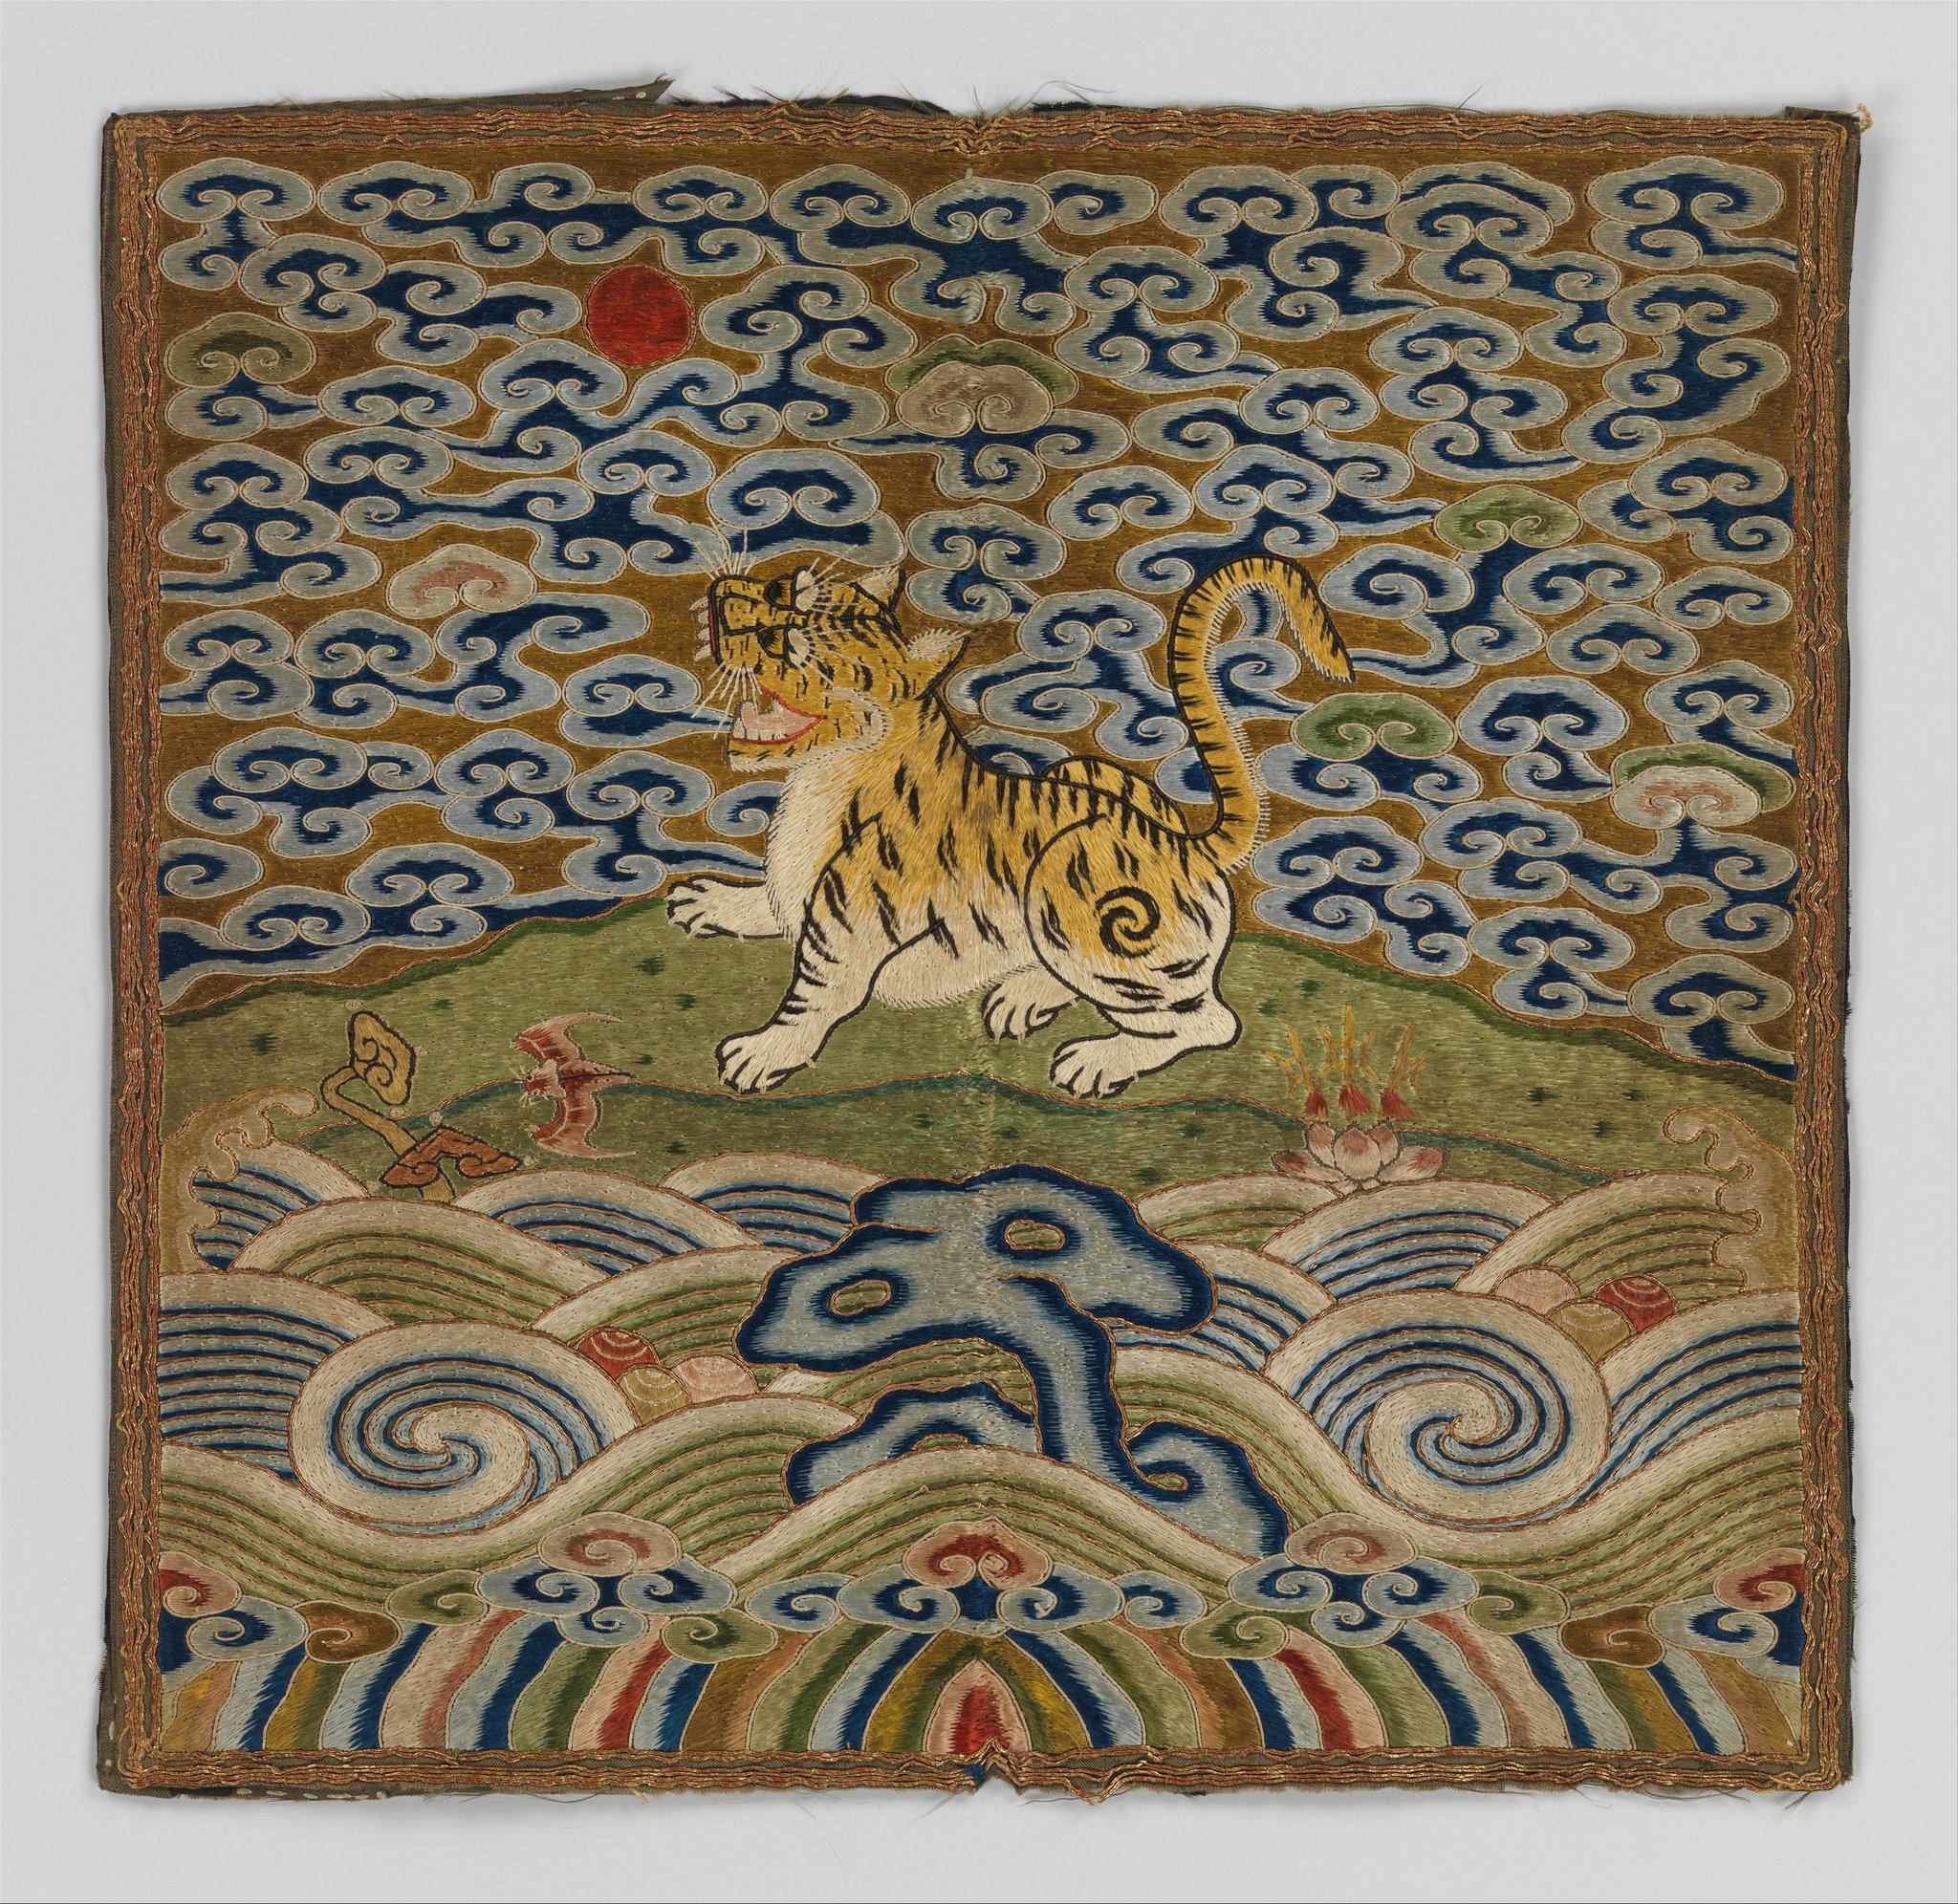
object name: rank badge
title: Rank badge with tiger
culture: chinese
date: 1701-1800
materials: metal thread, silk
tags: bats,tigers